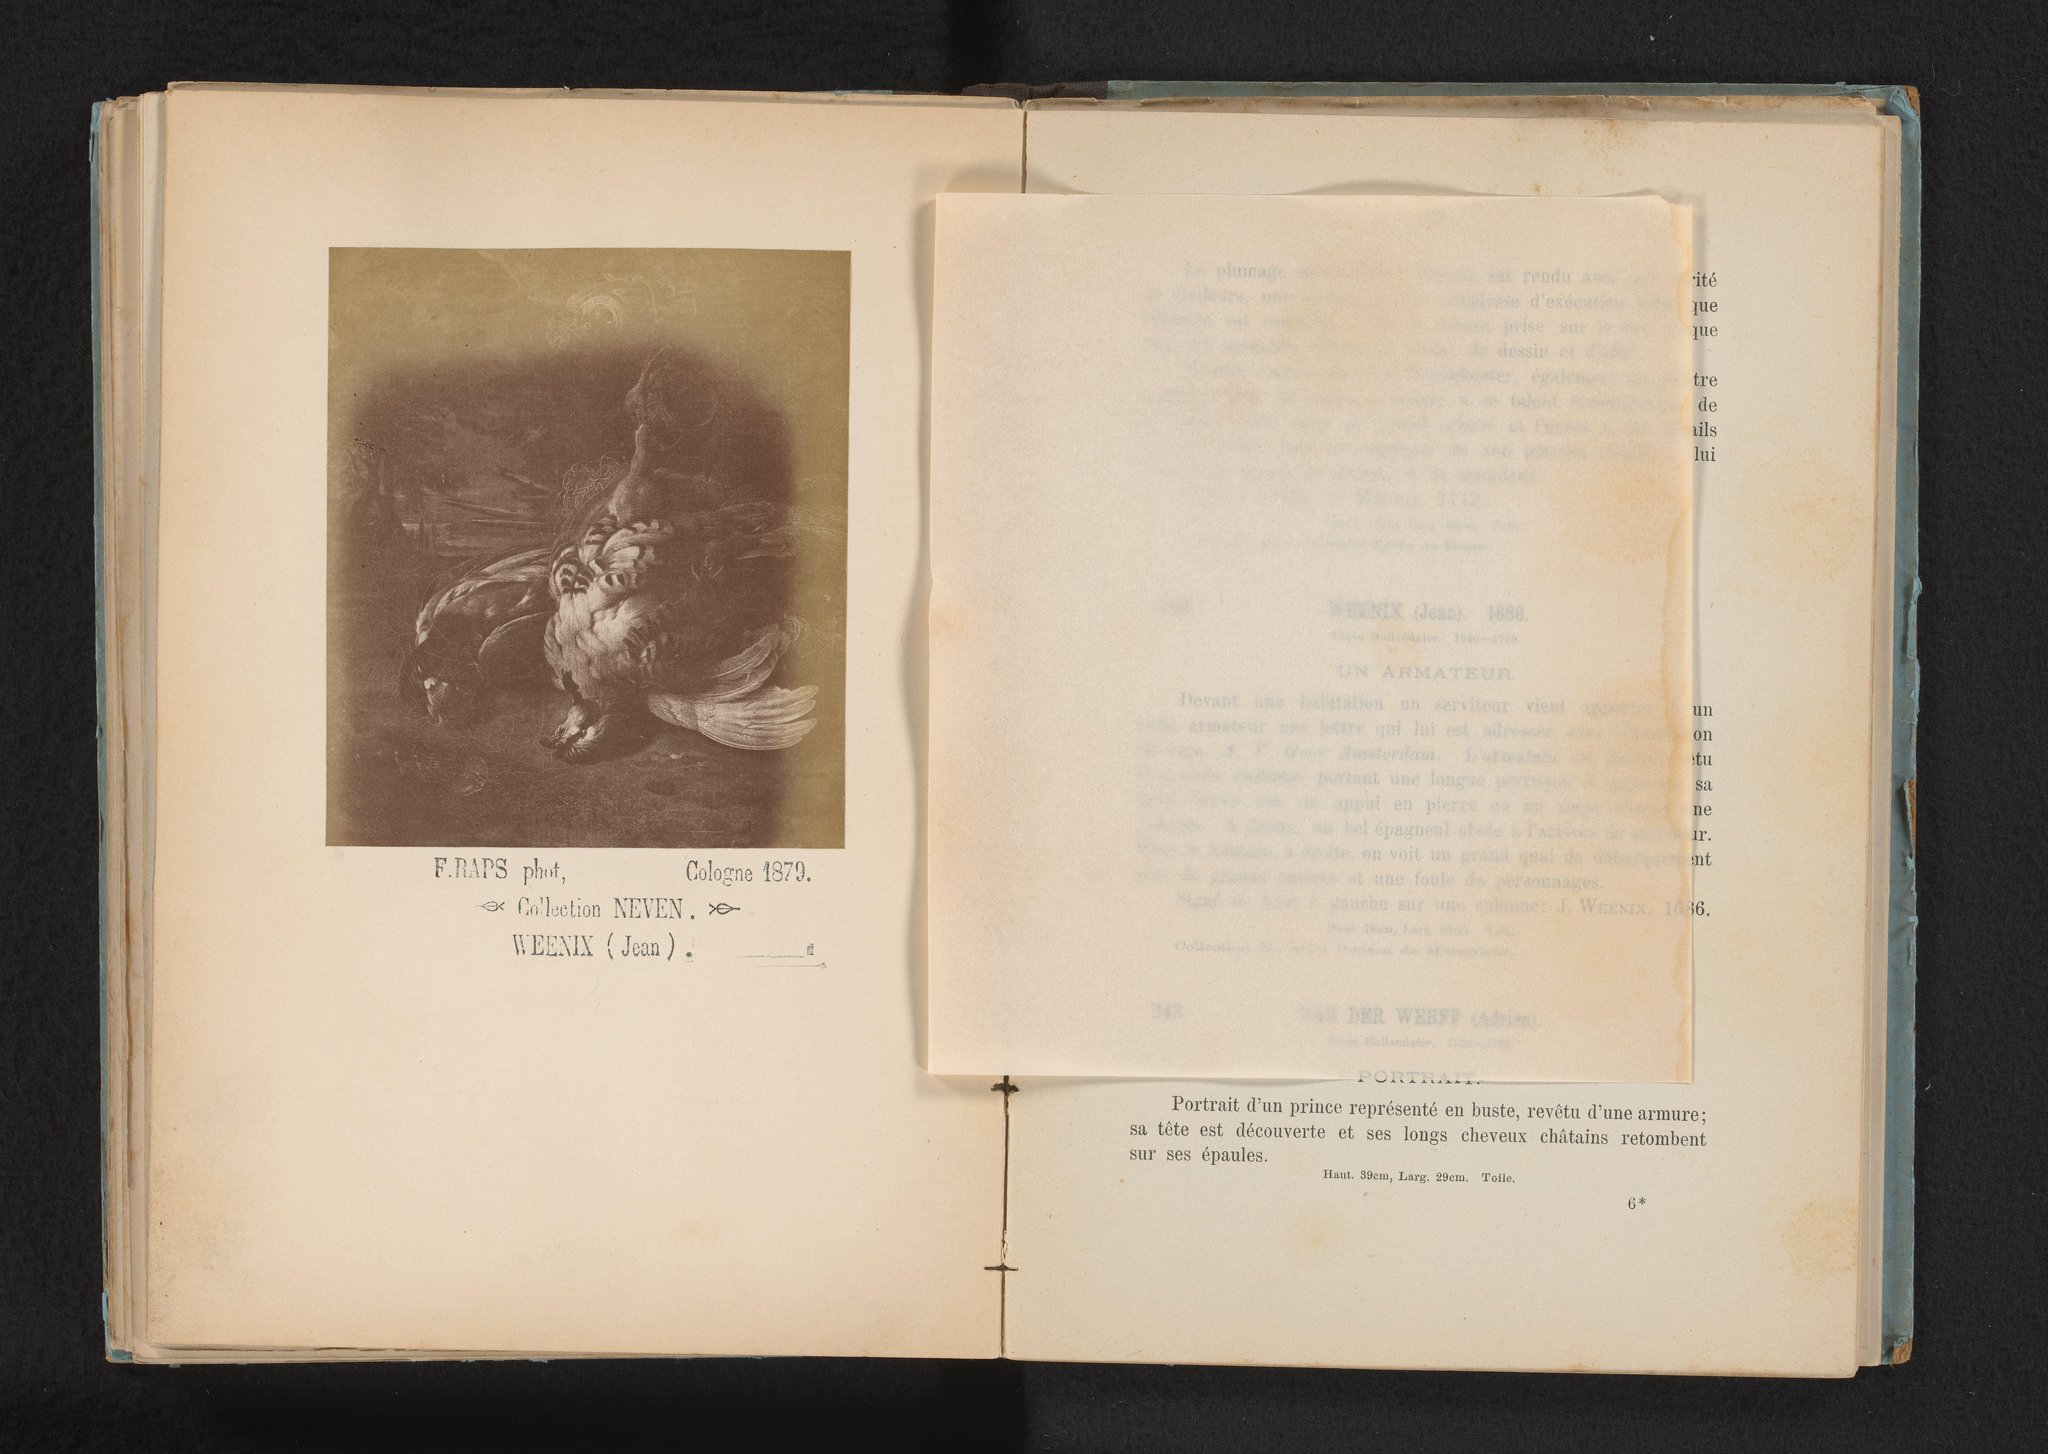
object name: page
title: Fotoreproductie van een schilderij van een stilleven van een patrijs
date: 1879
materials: photographic support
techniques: albumen print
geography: cologne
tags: walker and runner birds: partridge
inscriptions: inscription: ‘Collection NEVEN/ Weenix (Jean).’